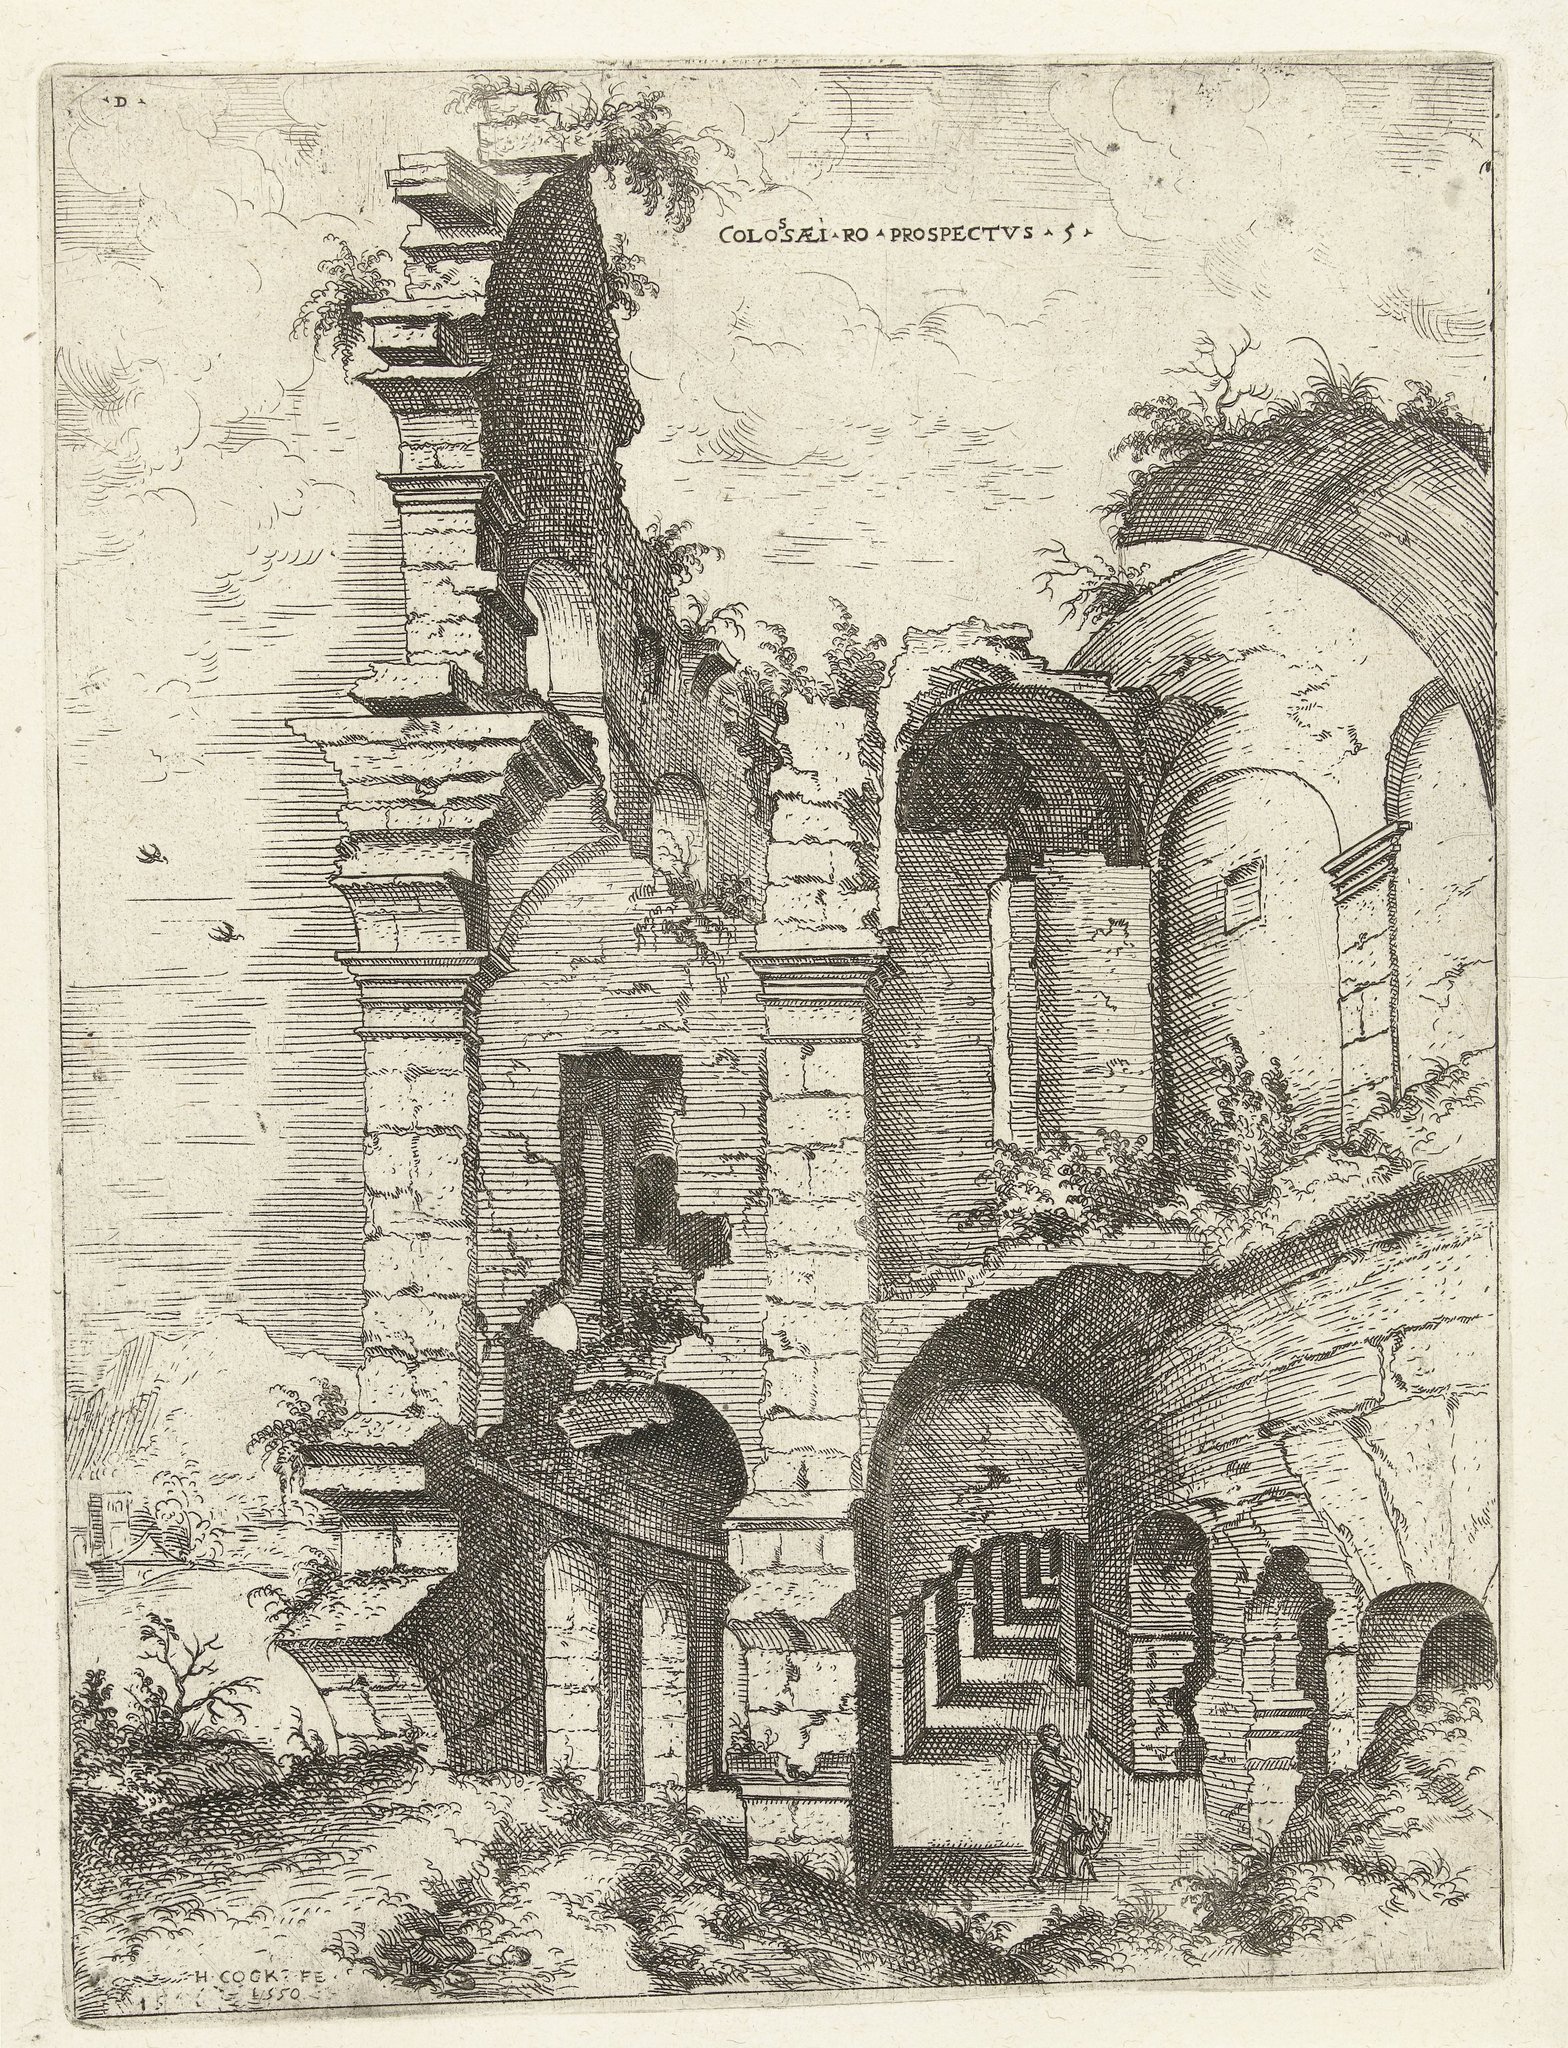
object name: print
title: Vijfde gezicht op het Colosseum te Rome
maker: hieronymus cock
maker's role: print maker, publisher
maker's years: 1518-1570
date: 1550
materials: paper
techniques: etching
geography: antwerp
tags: ruin of a building ~ architecture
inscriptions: collector's mark: Lugt 2228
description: Vijfde gezicht op de ruïnes van het Colosseum te Rome. Een man met hond loopt door de gangen van het gebouw. Prent uit een serie van 25 prenten met Romeinse ruïnes.